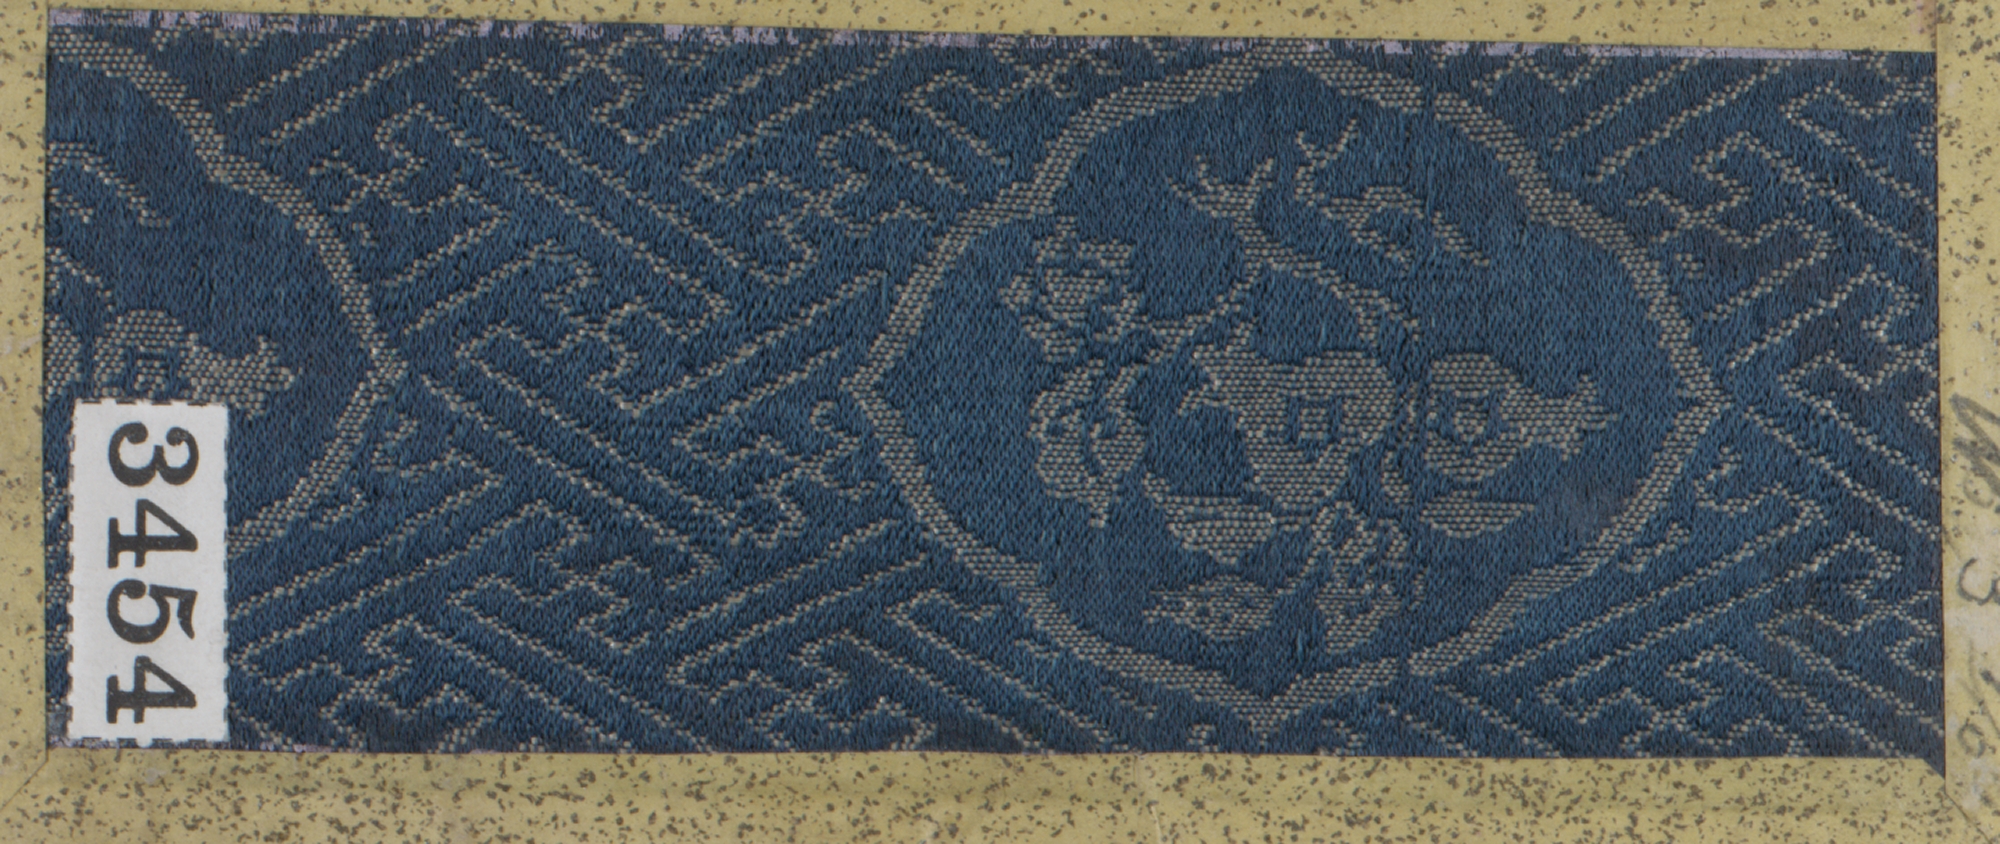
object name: sample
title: Textile Sample from Sample Book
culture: japanese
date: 1801-1900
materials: silk